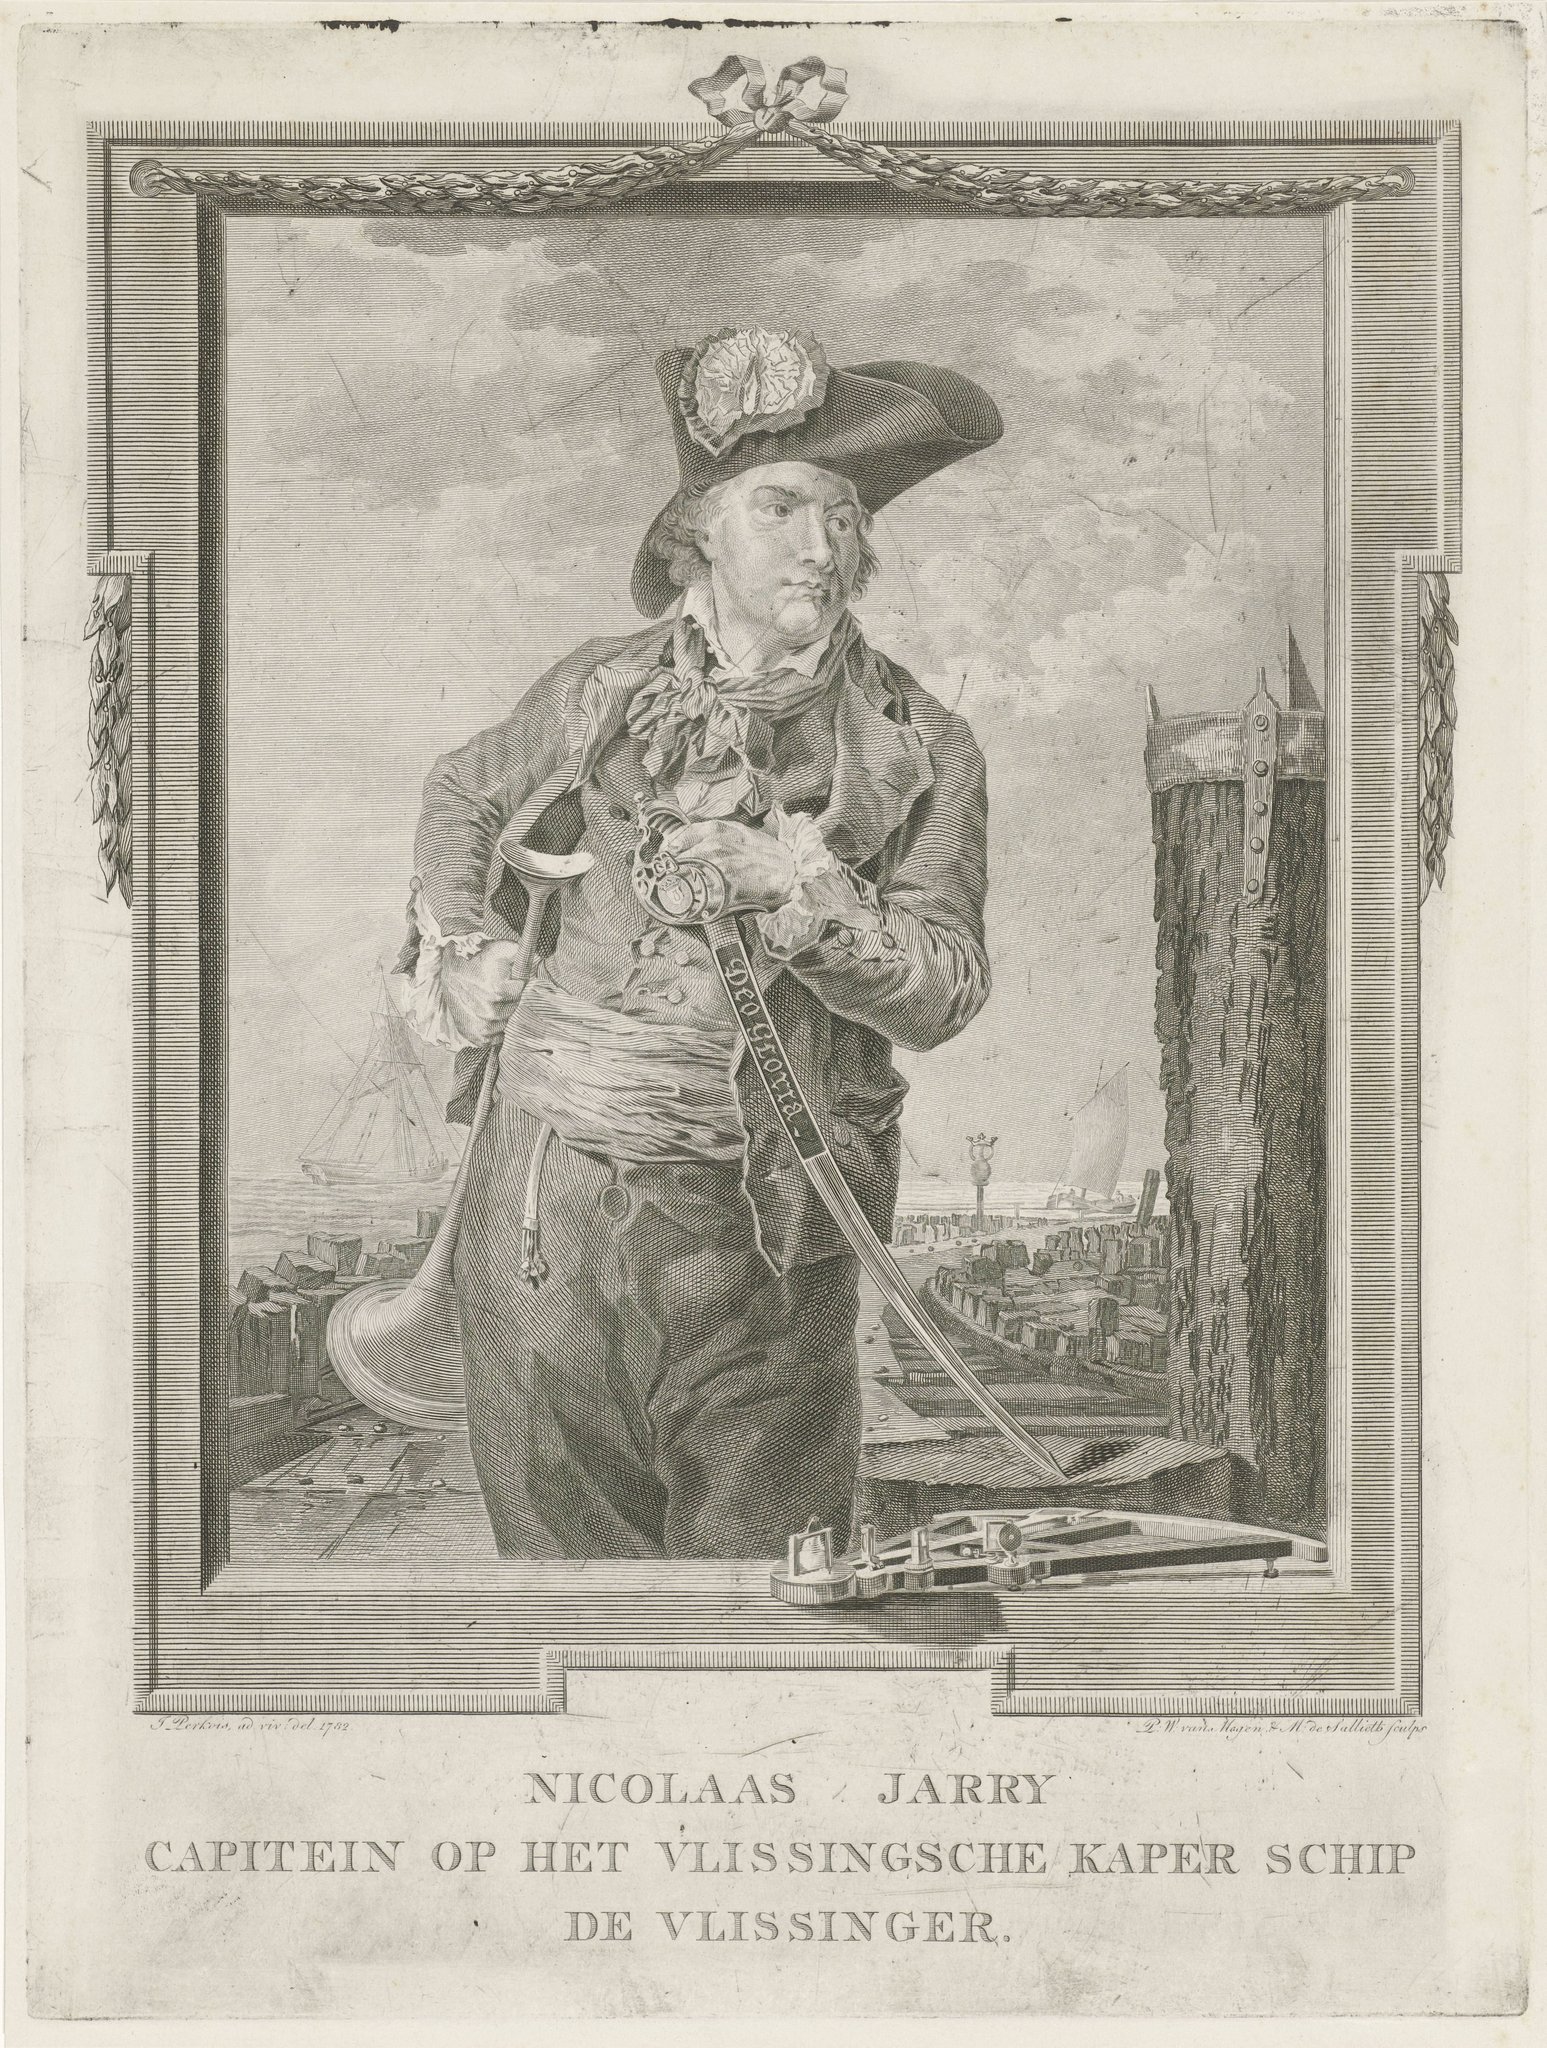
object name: print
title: Portret van Nicolas Jarry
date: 1782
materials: paper, pencil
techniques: etching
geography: the hague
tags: quadrant, sextant, octant (nautical instruments)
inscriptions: collector's mark: Lugt 2228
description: Portret van Nicolas Jarry, kaper en kapitein, met in de ene hand een scheepshoorn en in de andere hand een sabel. Onder op de lijst ligt een sextant. Op de achtergrond twee schepen op zee.